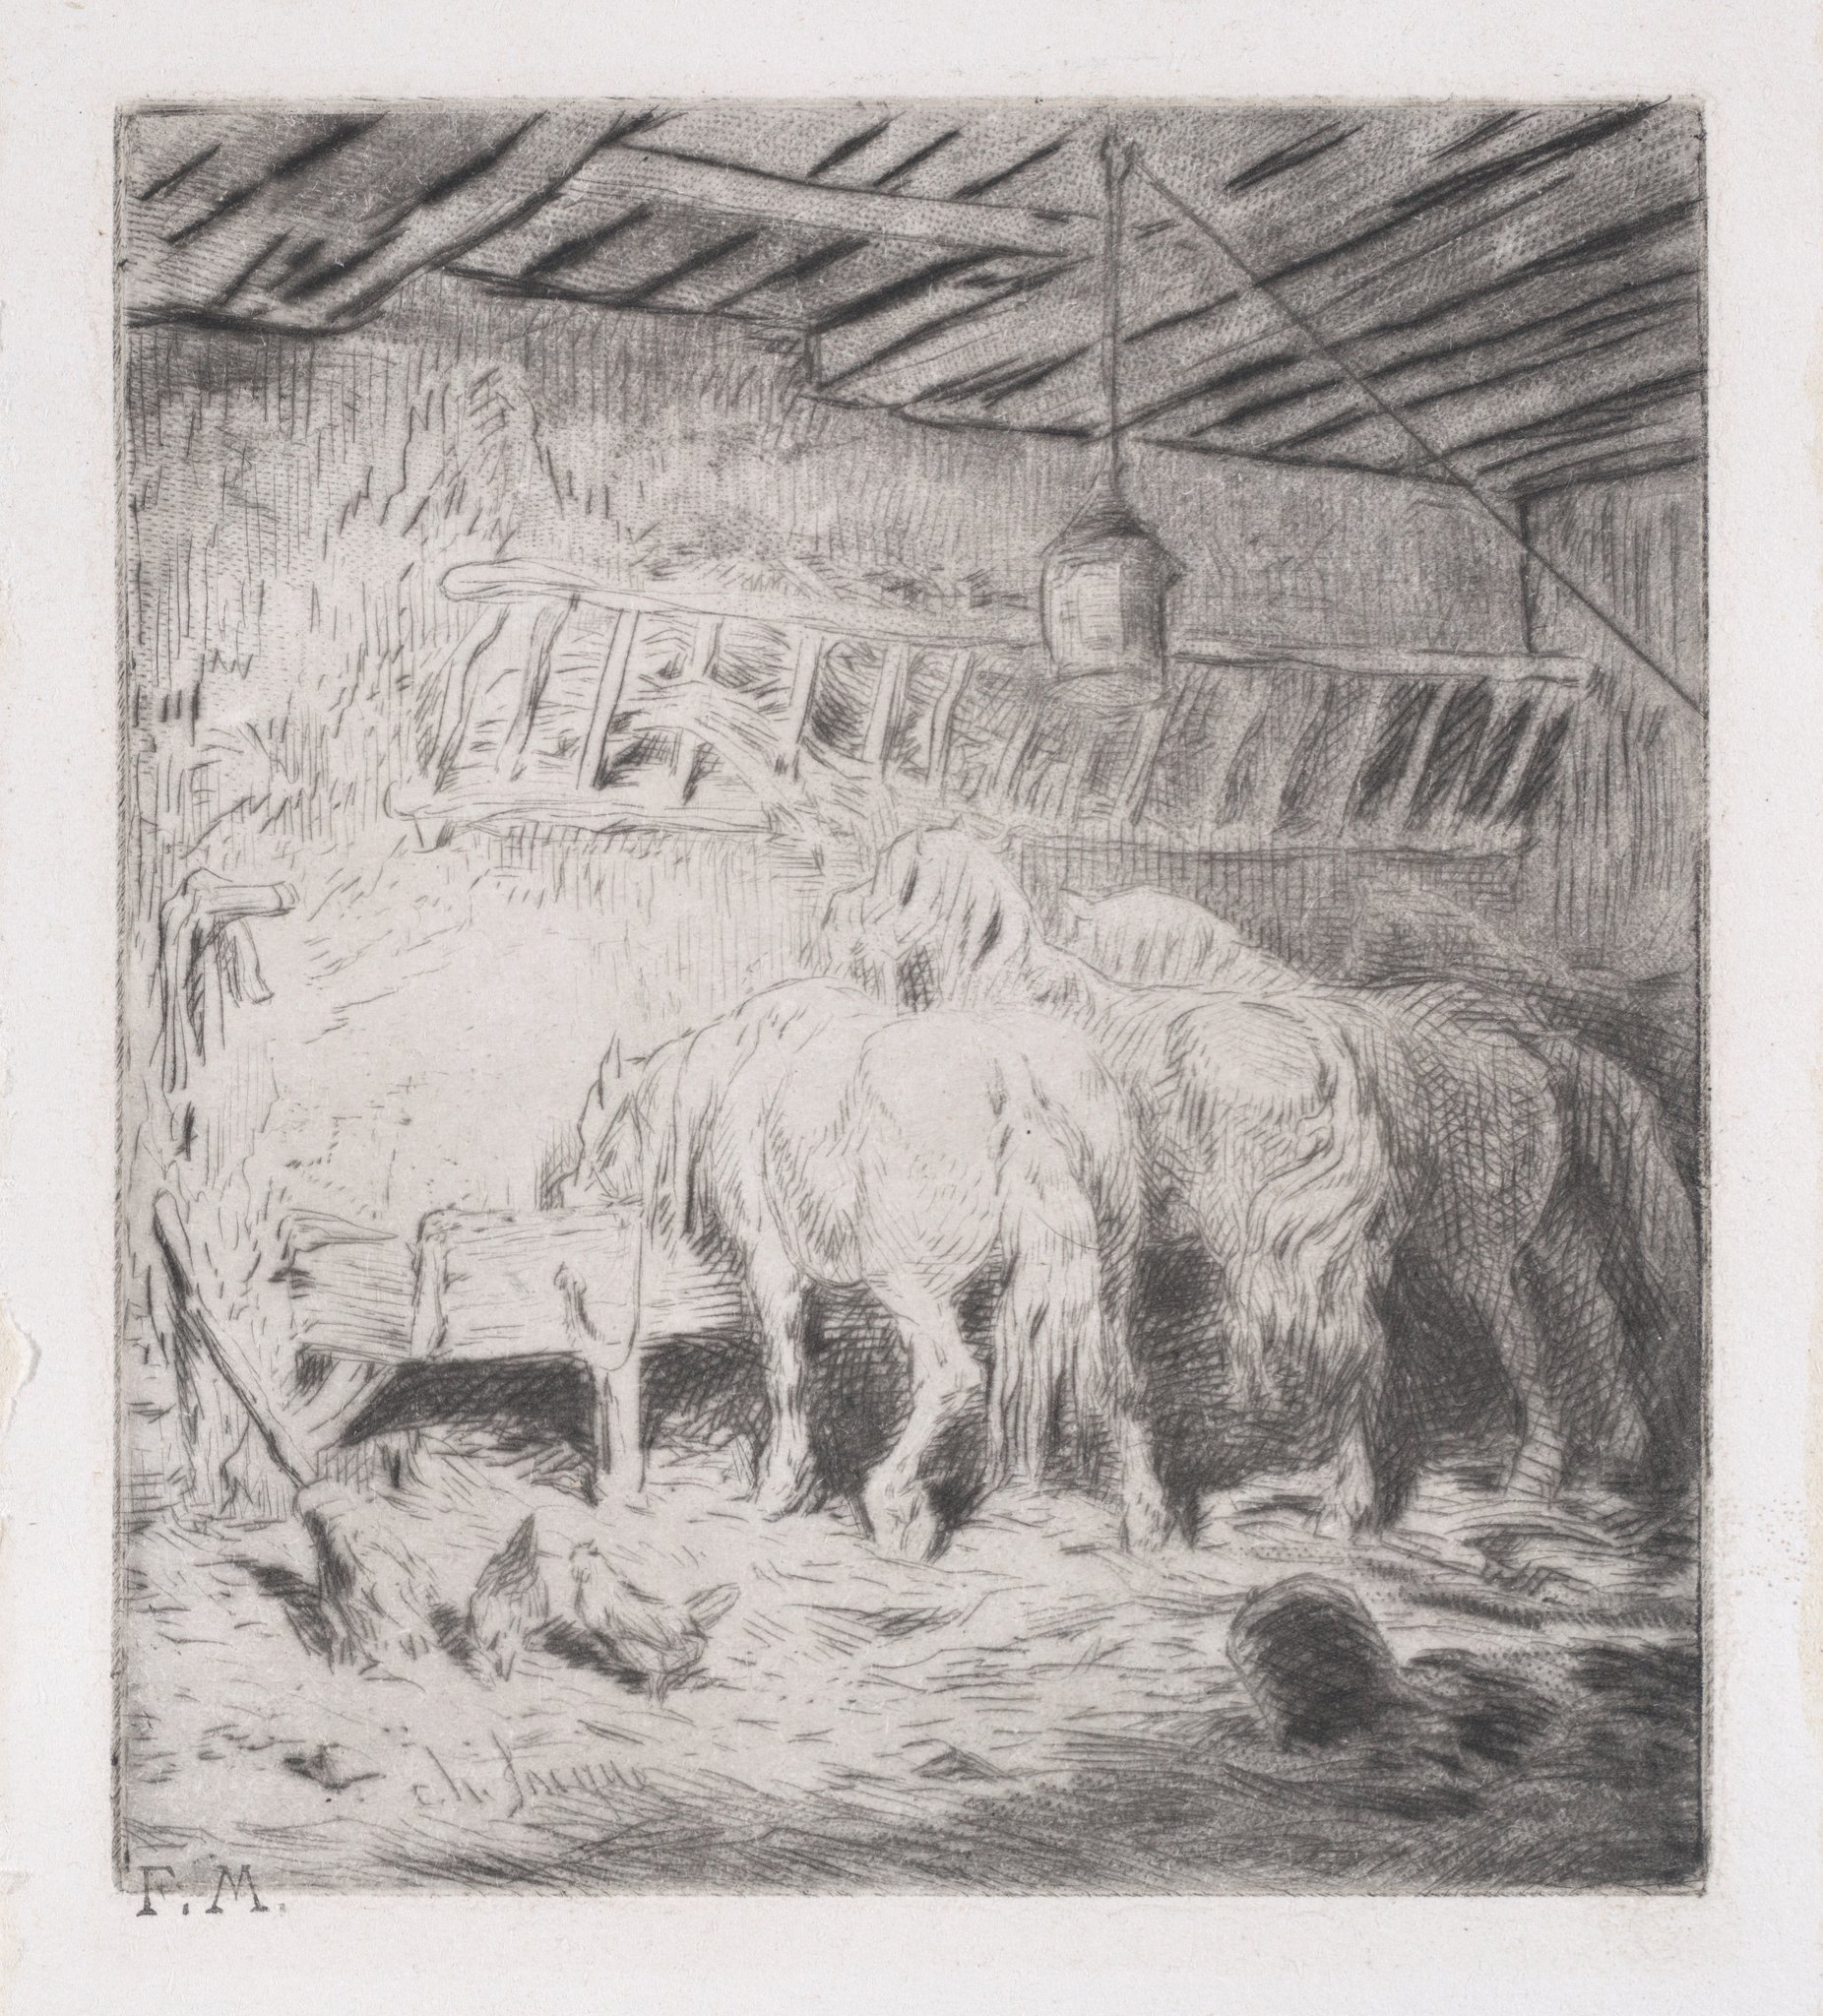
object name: print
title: Stable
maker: charles émile jacque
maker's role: artist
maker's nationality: french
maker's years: 1813-1894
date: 1848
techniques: drypoint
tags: horses